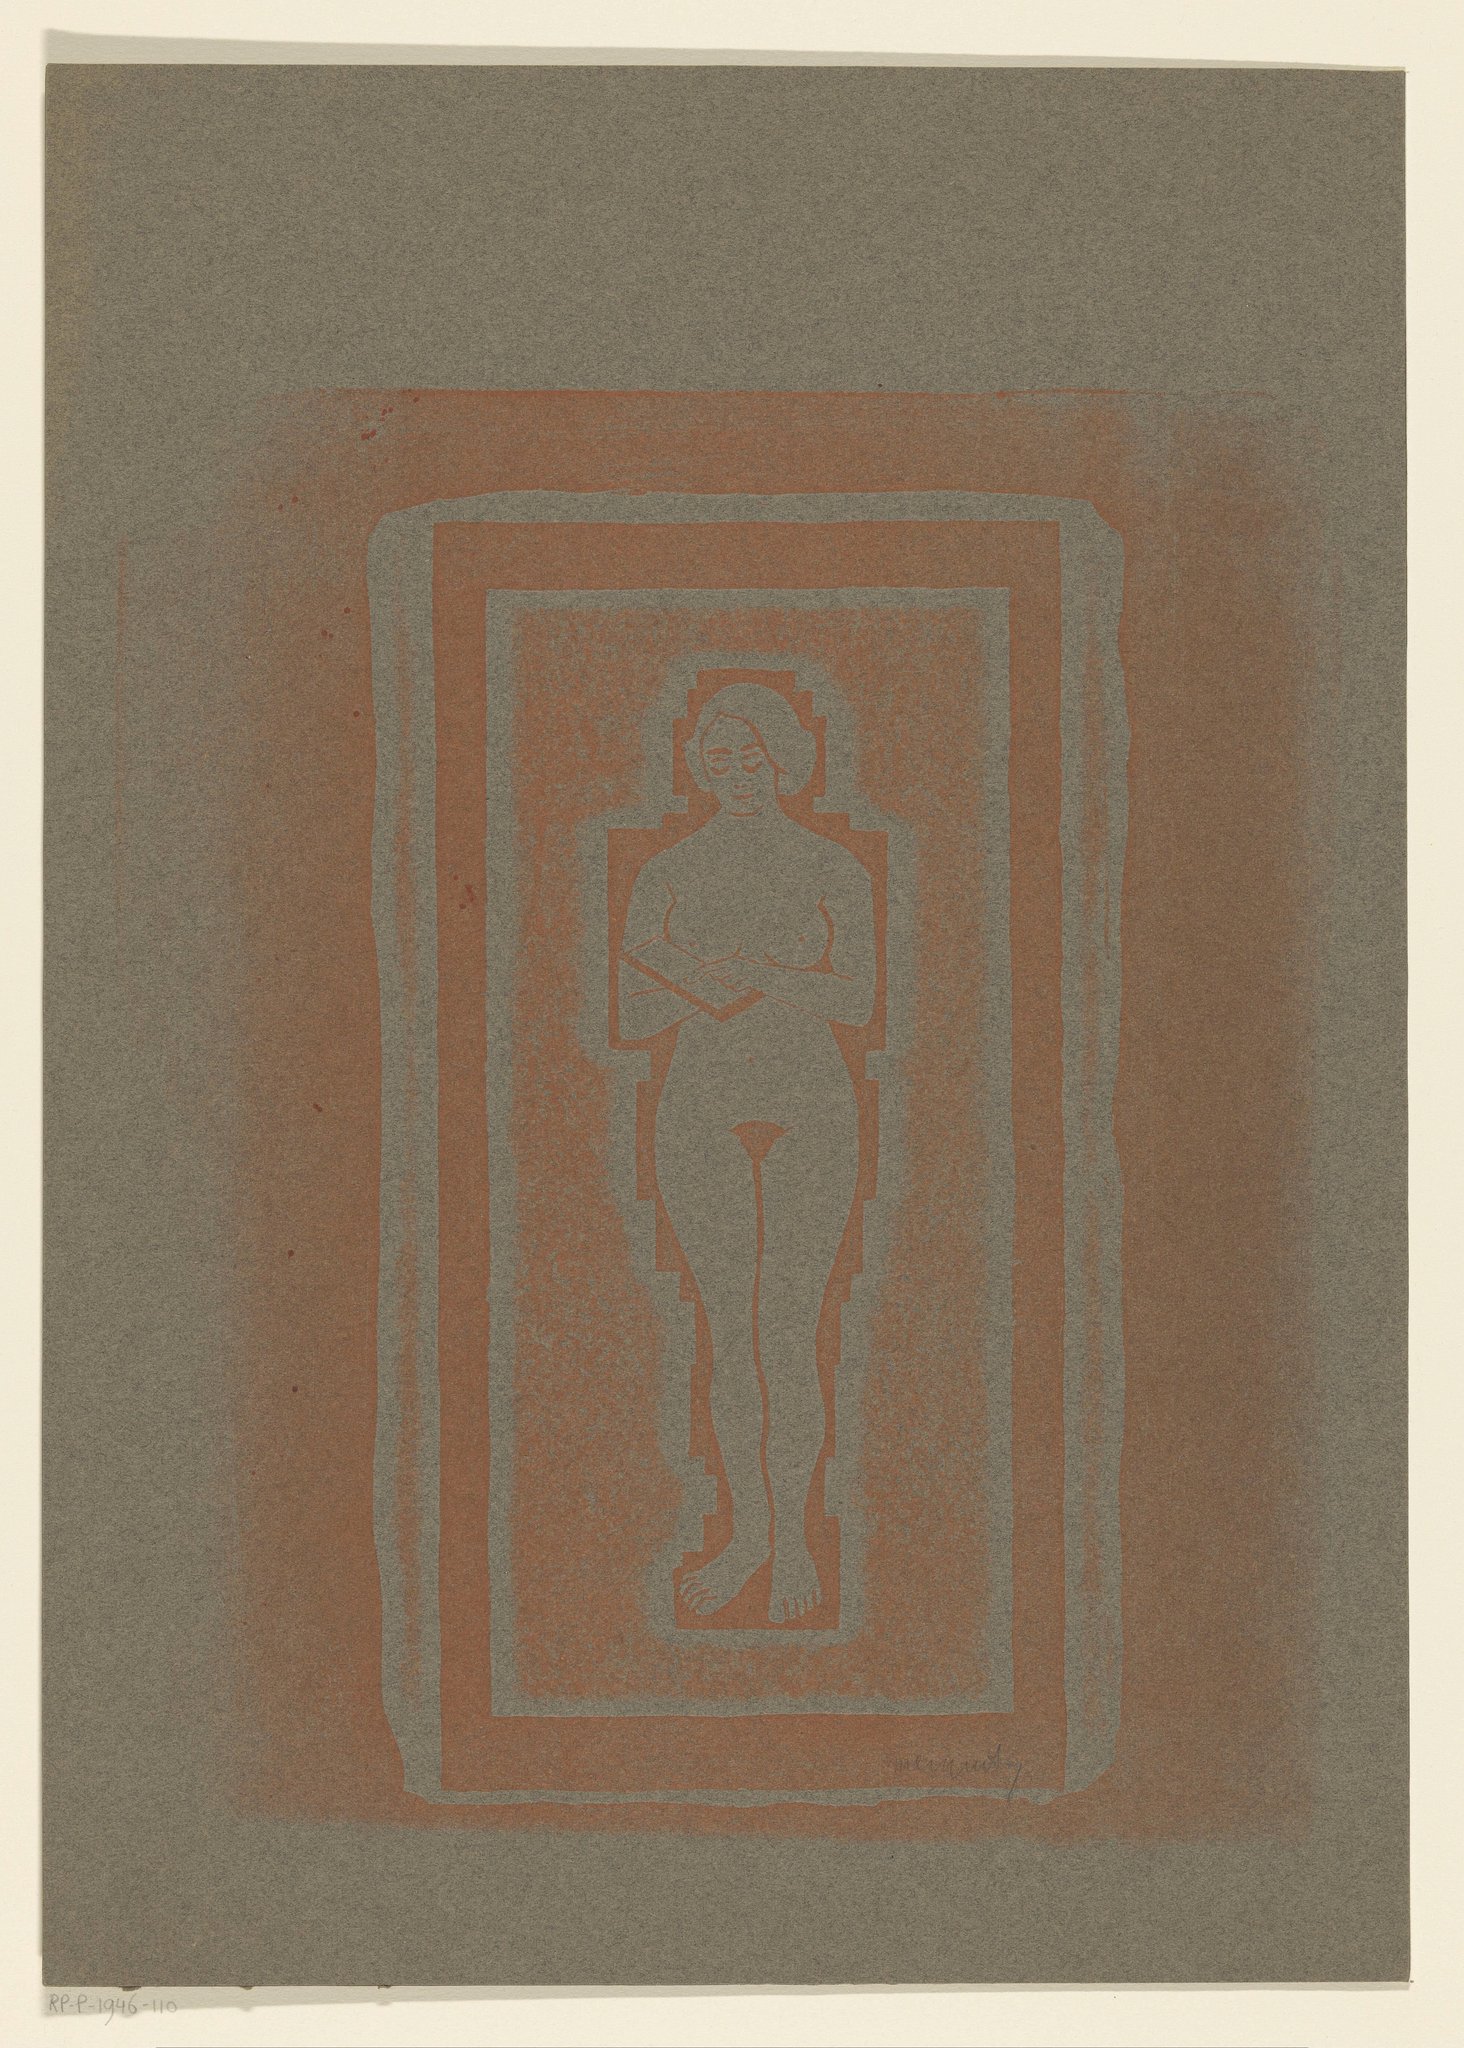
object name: print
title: Naakt met boek of stenen plaat in de hand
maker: samuel jessurun de mesquita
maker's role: draughtsman, print maker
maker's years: 1868-1944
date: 1924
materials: paper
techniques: lithograph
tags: woman (showing herself) undressed, quasi-nude, book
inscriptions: collector's mark: Lugt 2228